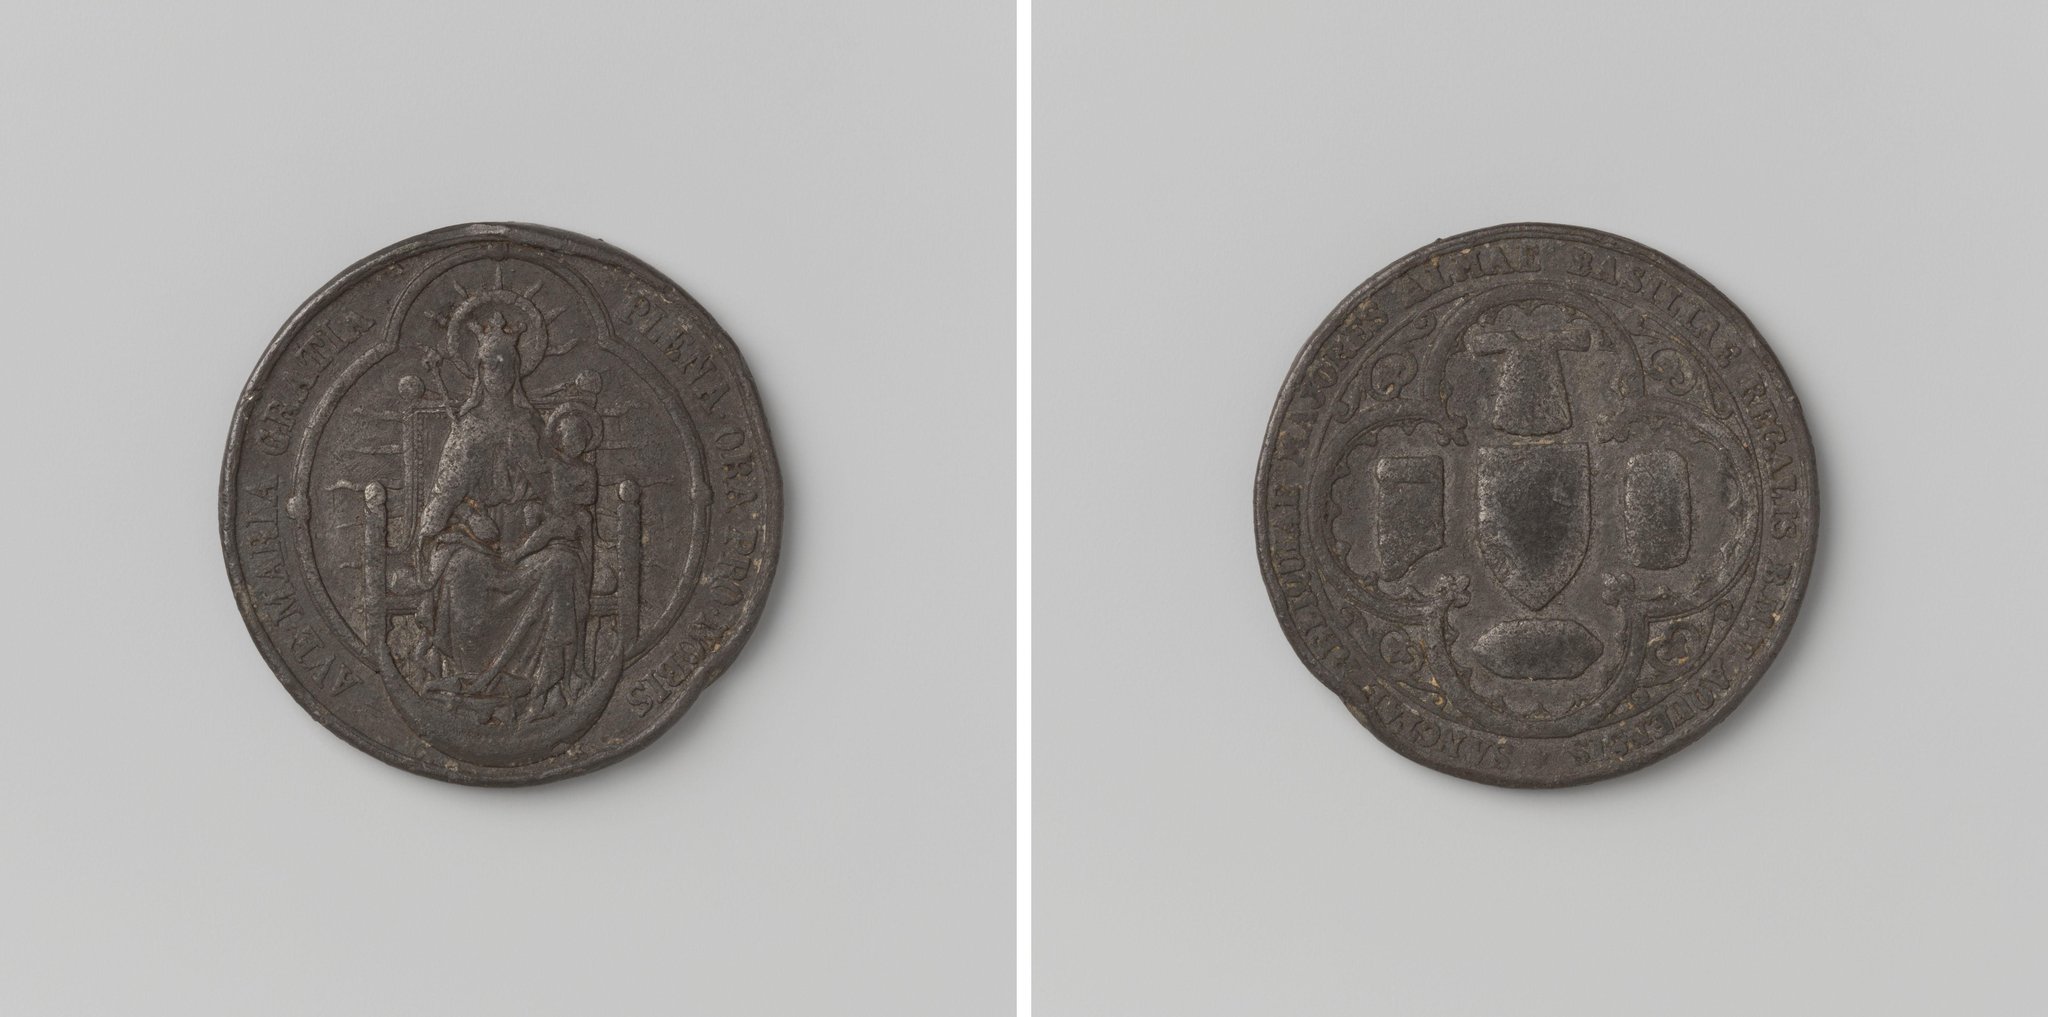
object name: devotional medal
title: Maria en Christuskind, devotiepenning van Aquensis(?) of de heilige Basilla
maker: Anonymous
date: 1600-1800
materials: lead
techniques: striking